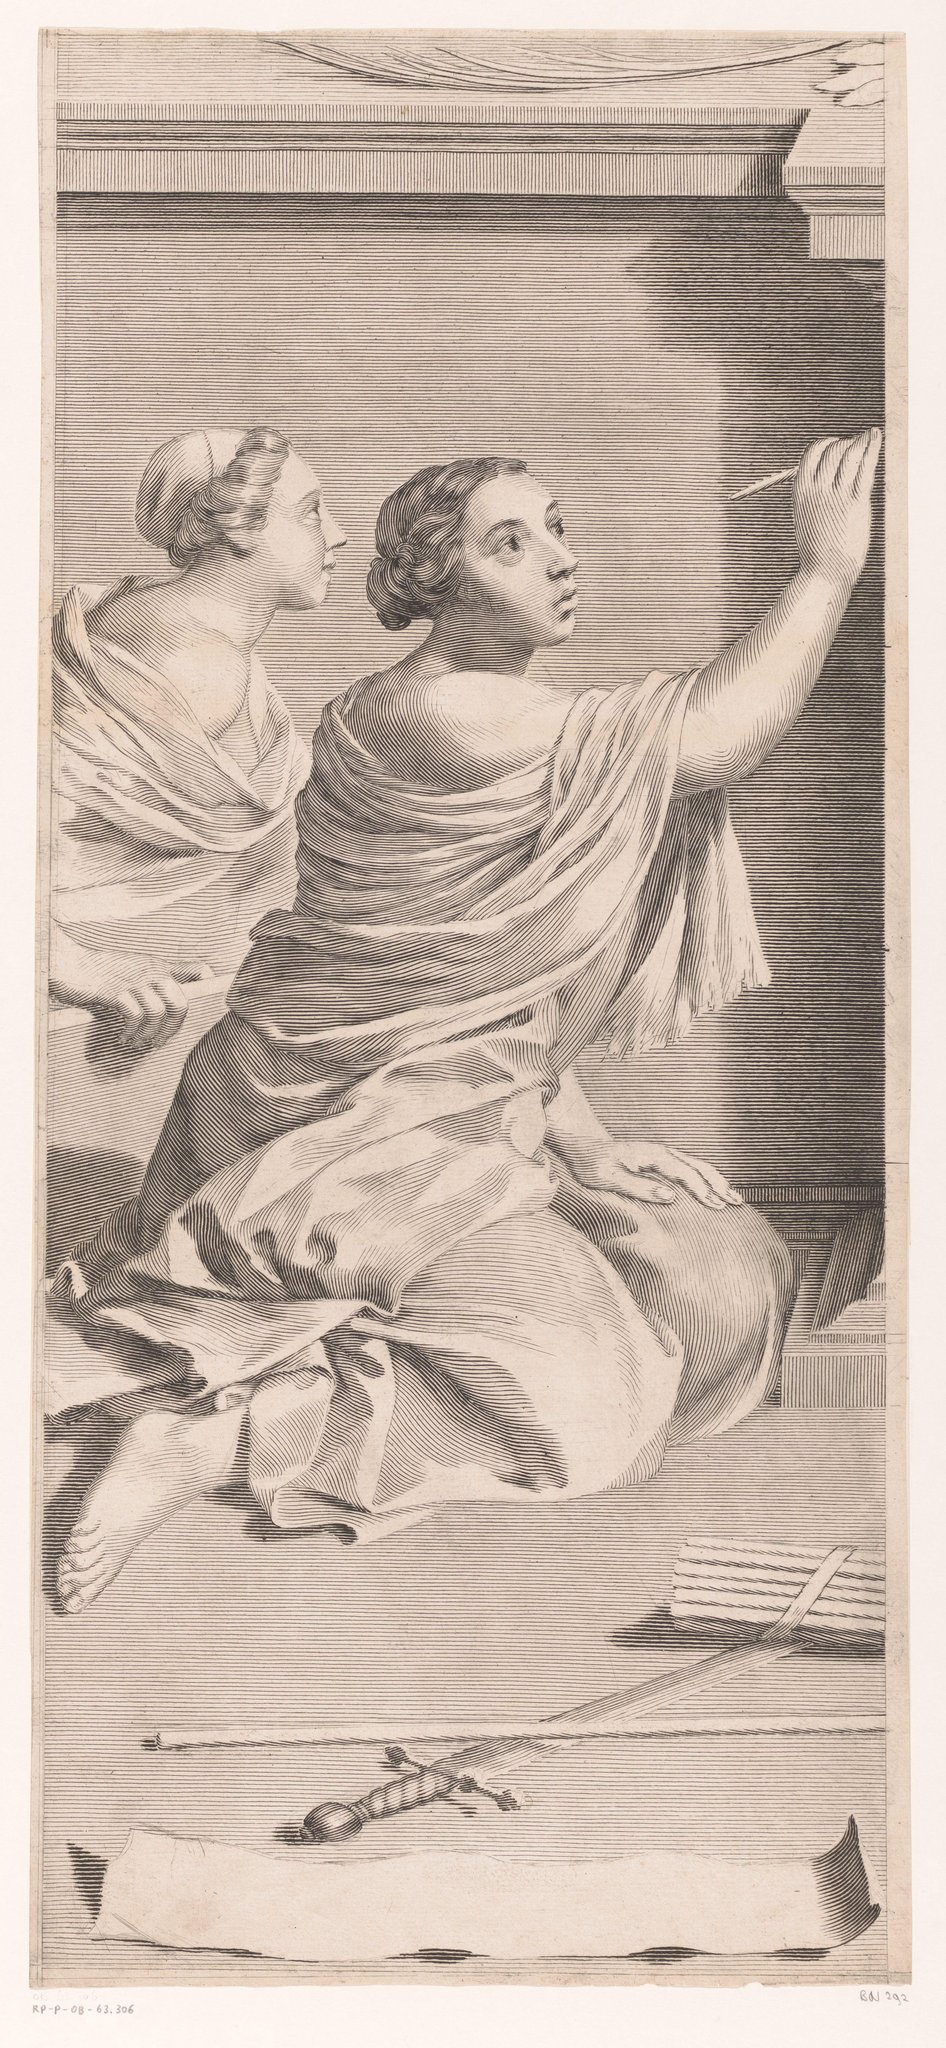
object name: print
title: These over theologie van Antoine Talon (linkeronderdeel)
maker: claude mellan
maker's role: draughtsman, print maker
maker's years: 1598-1688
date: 1648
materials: paper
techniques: engraving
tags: hacking and thrusting weapons: sword, materials to write on, writing surfaces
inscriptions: collector's mark: Lugt 2228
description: Zittende vrouw, schrijvend met stift op stenen tablet. Op de grond zwaard en pijlen.